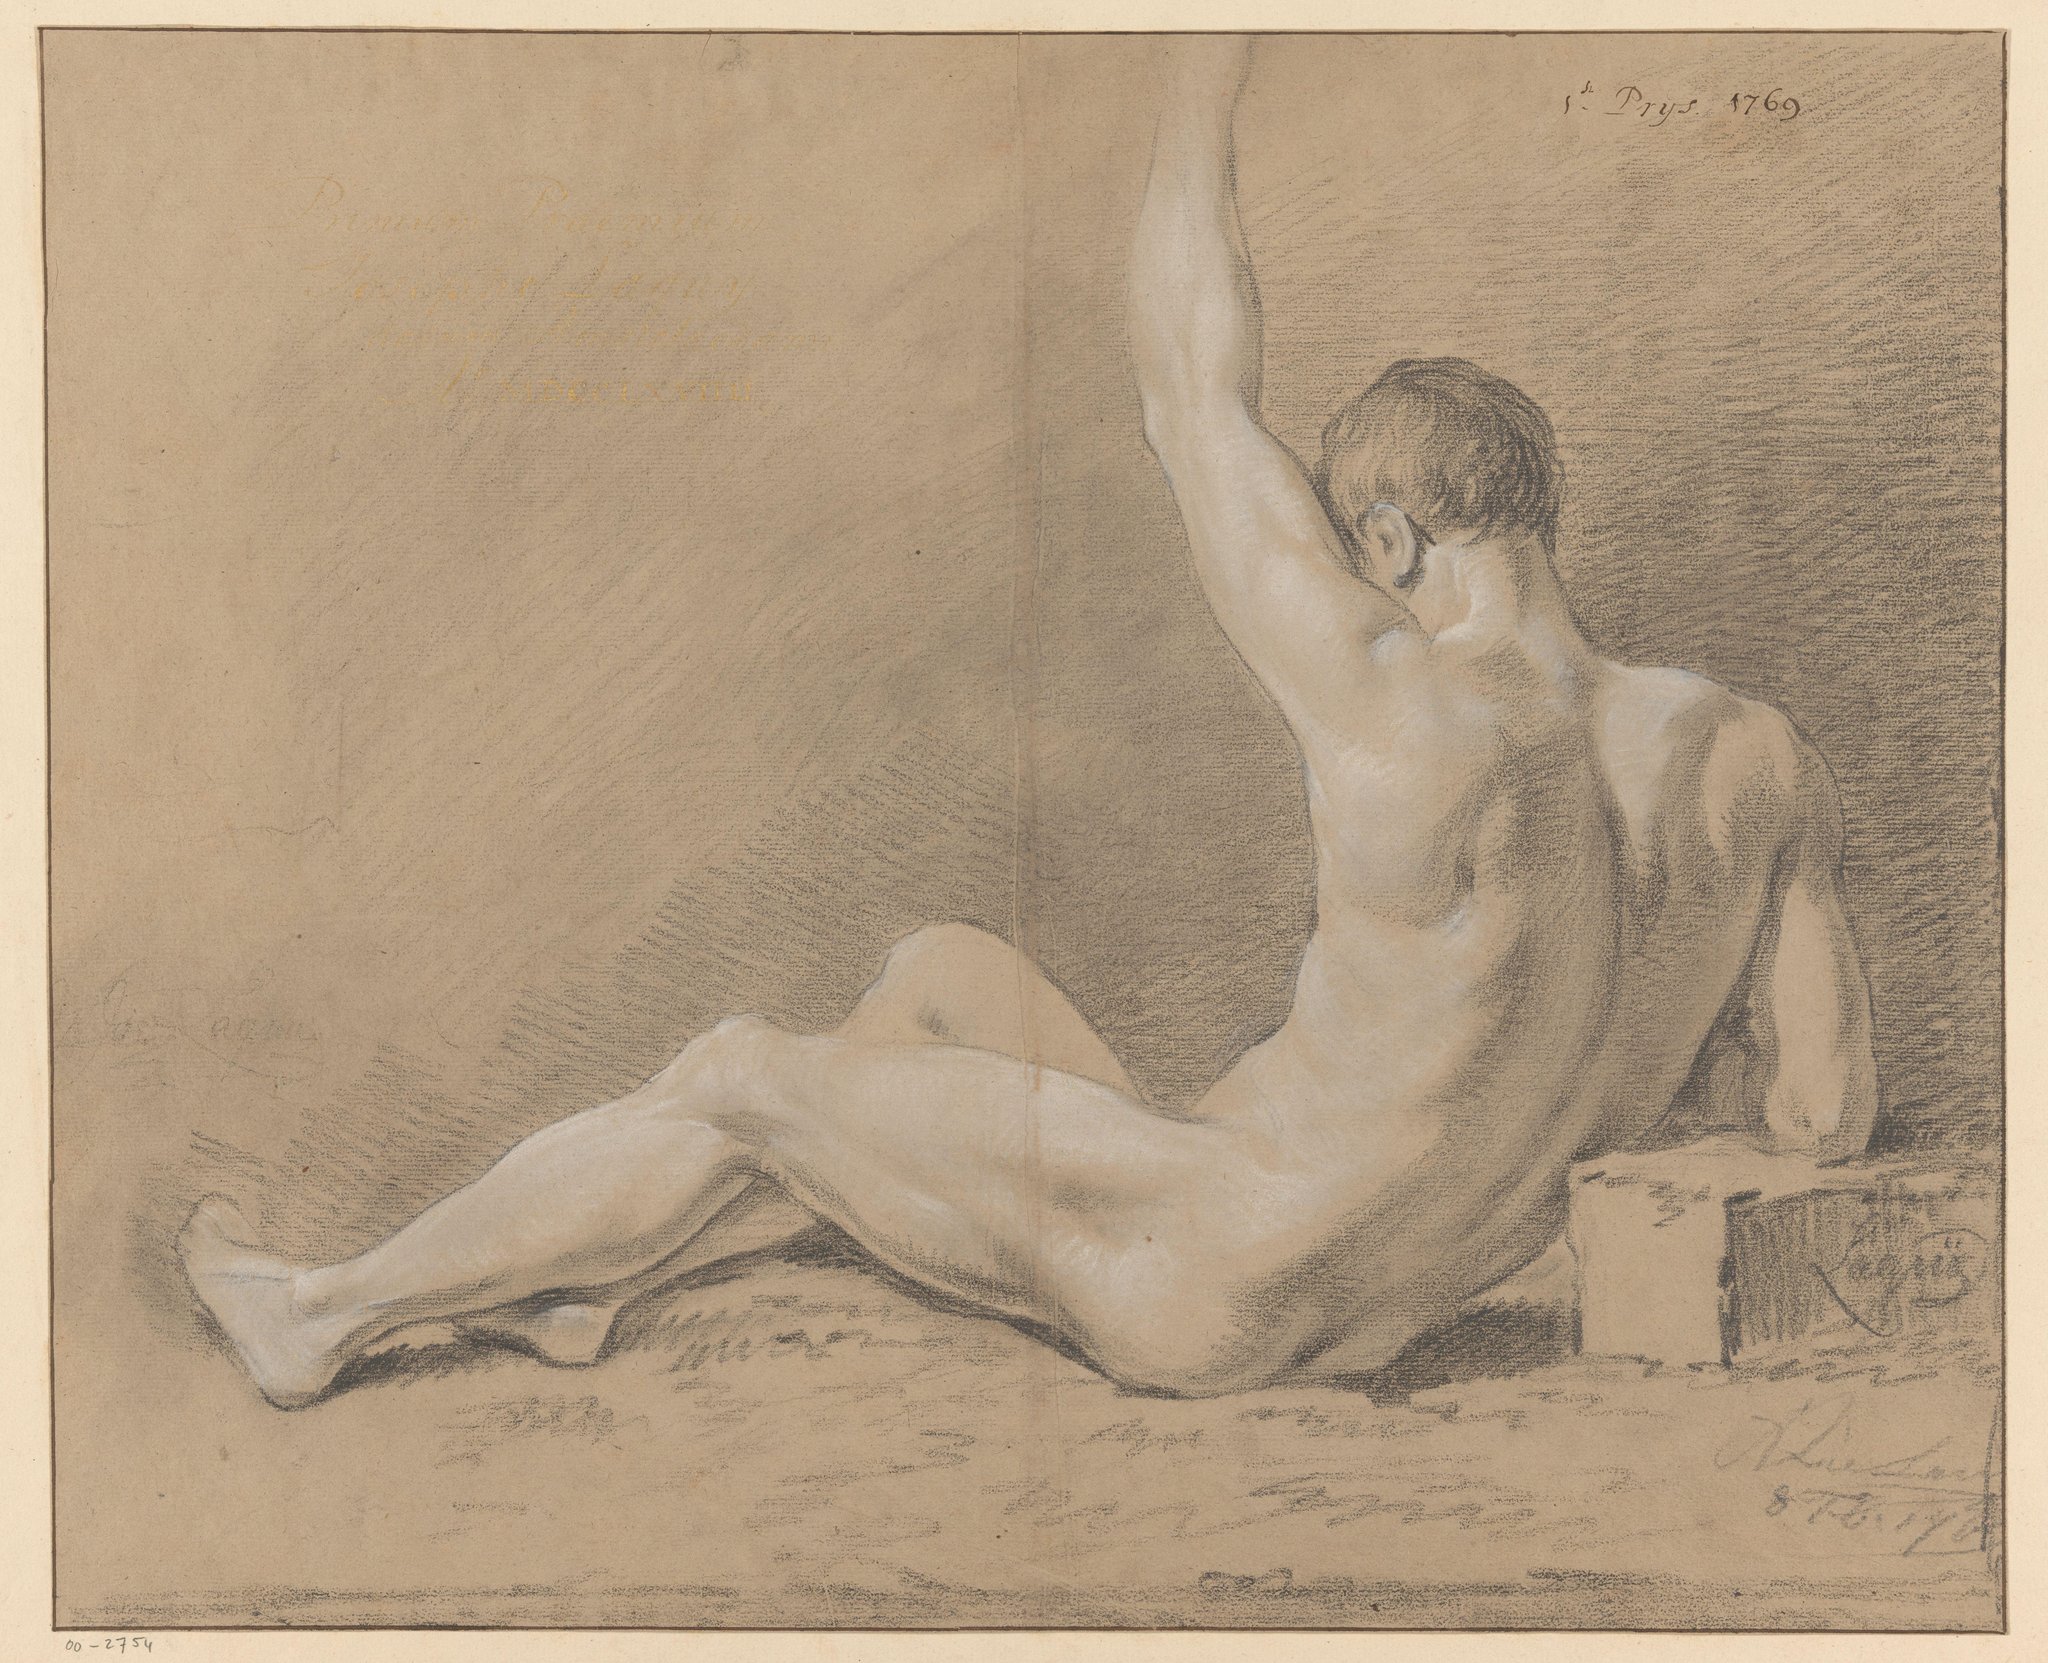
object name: drawing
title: zittend mannelijk naakt, op de rug gezien (1e prijs 1769)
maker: willem joseph laquy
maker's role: draughtsman, painter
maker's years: 1738-1798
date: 1769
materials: chalk, paper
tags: sitting figure (+ nude human being)